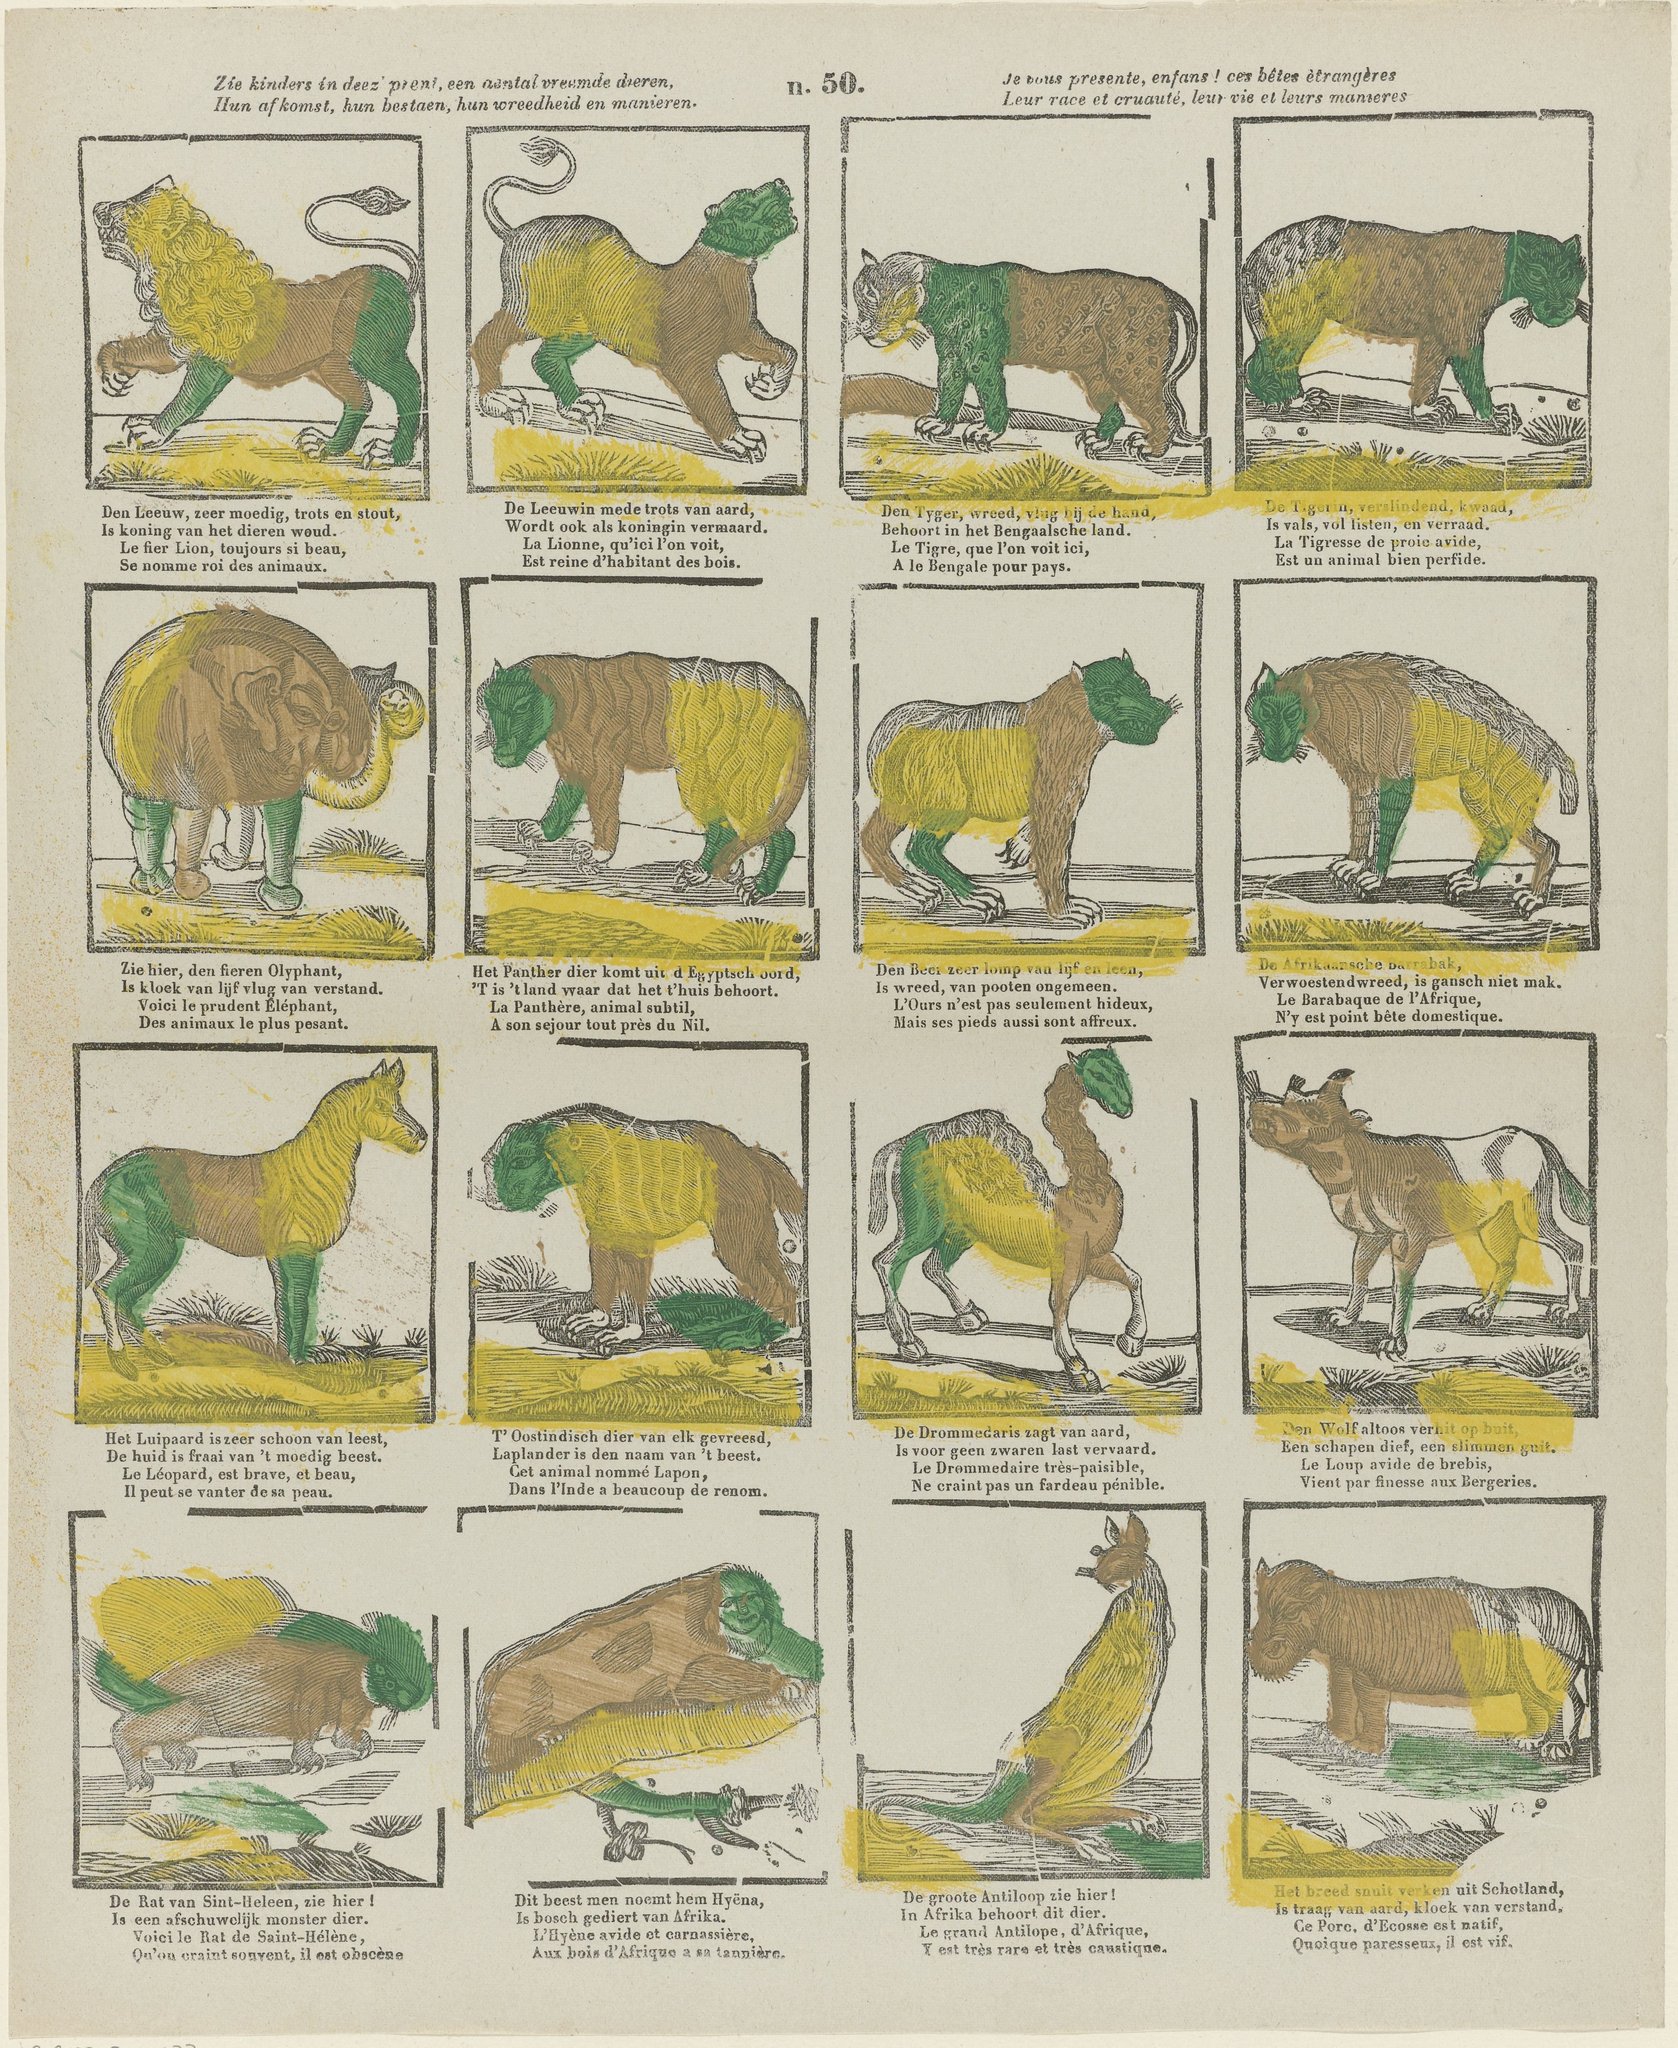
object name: print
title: Zie kinders in deez' prent, een aantal vreemde dieren, / Hun afkomst, hun bestaen, hun wreedheid en manieren / Je vous presente, enfans! ces bêtes ètrangères / Leur race et cruauté, leur vie et leurs manieres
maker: Anonymous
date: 1856-1900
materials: paper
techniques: colour, letterpress printing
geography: turnhout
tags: beasts of prey, predatory animals: tiger, hoofed animals: dromedary, animals, beasts of prey, predatory animals: lion, trunked animals: elephant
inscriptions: collector's mark: Lugt 2760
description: Blad met 16 voorstellingen van dieren, zoals een leeuw, een tijger, een olifant en een zebra. Onder elke afbeelding een tweeregelig vers in het Nederlands en in het Frans. Genummerd midden boven: n. 50.